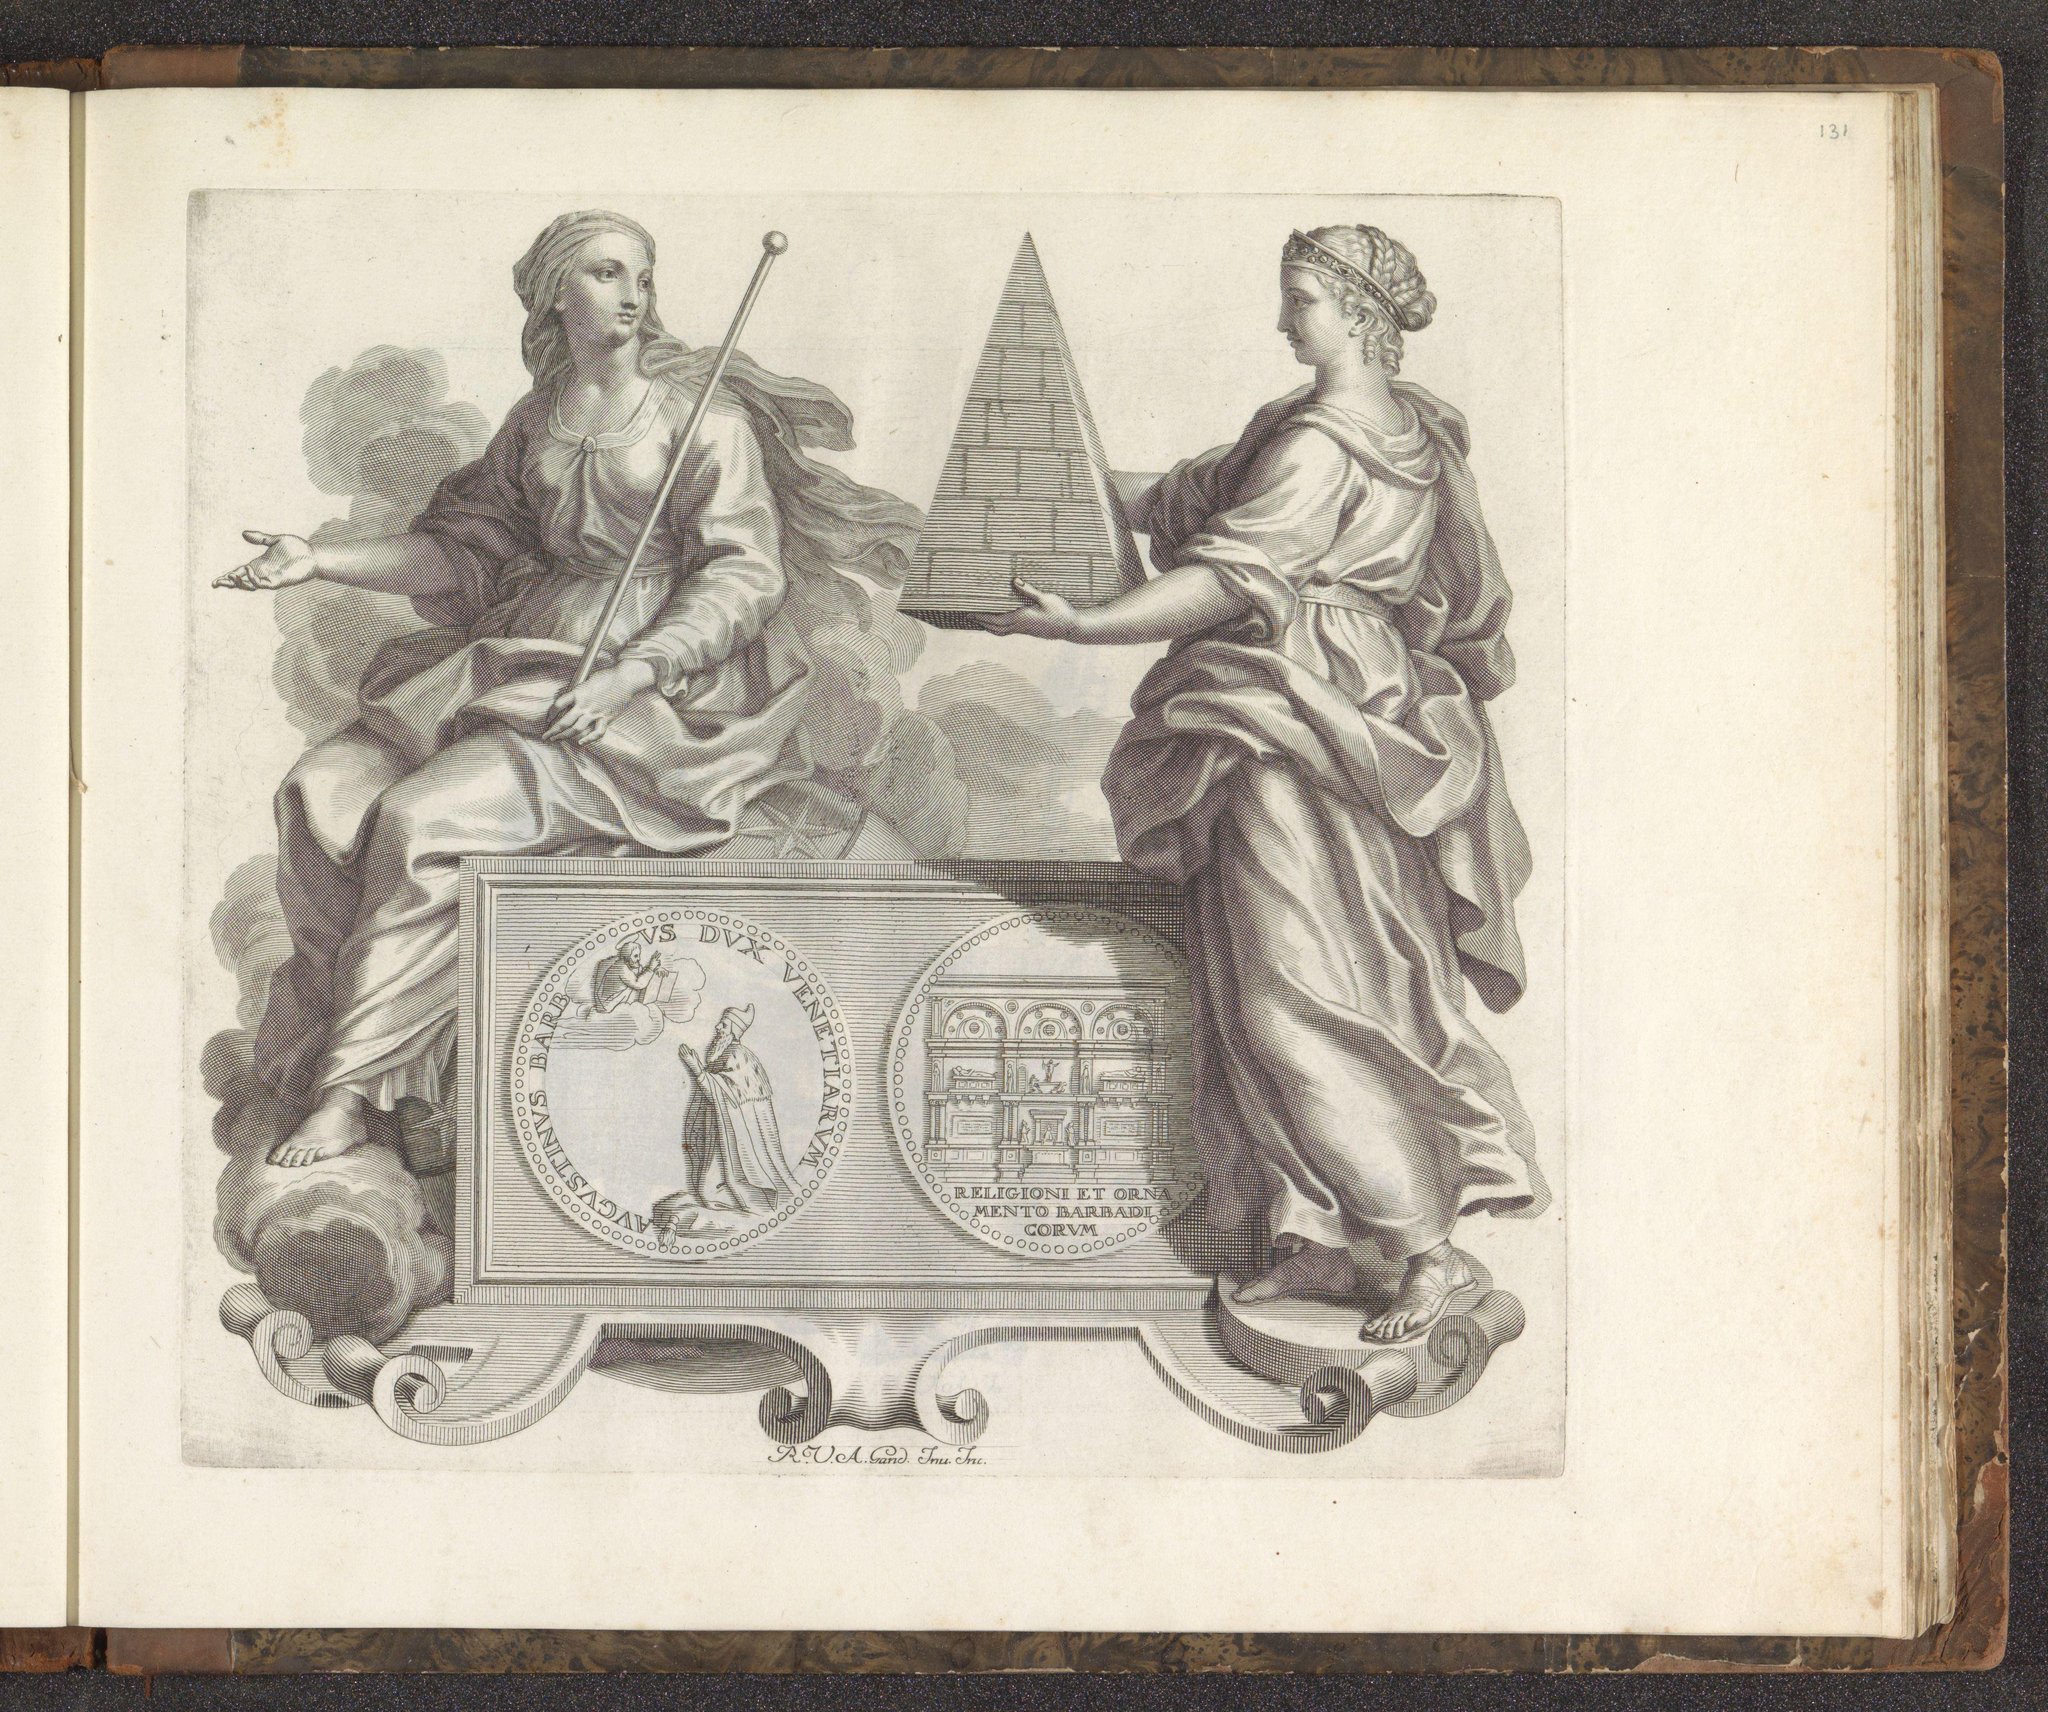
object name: print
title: Doge Agostino Barbarigo knielend voor Christus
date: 1673-1743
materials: paper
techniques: engraving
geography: rome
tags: pyramid ~ stereometry, other sovereign: doge, grave, tomb and other grave-forms and grave-markers, honour, glory; 'ampiezza della gloria', 'gloria', 'gloria de prencipi', 'gloria & honore', 'honore', 'sublimatà della gloria' (ripa)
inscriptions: collector's mark: Lugt 2228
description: Voetstuk in de vorm van een cartouche. Daarop een medaillon met op de voorzijde doge Agostino Barbarigo knielend voor Christus in de wolken. Op de achterkant wordt een gedenkteken opgedragen aan Marco en Agostino Barbarigo. Het voetstuk wordt geflankeerd door twee vrouwelijke personificaties. Links zit een vrouw op een hemelglobe tussen de wolken en met een roede in haar hand. Rechts de personificatie van de Roem: een vrouw met een gouden ring met edelstenen als kroon en een piramide in haar handen. De prent maakt deel uit van een album.